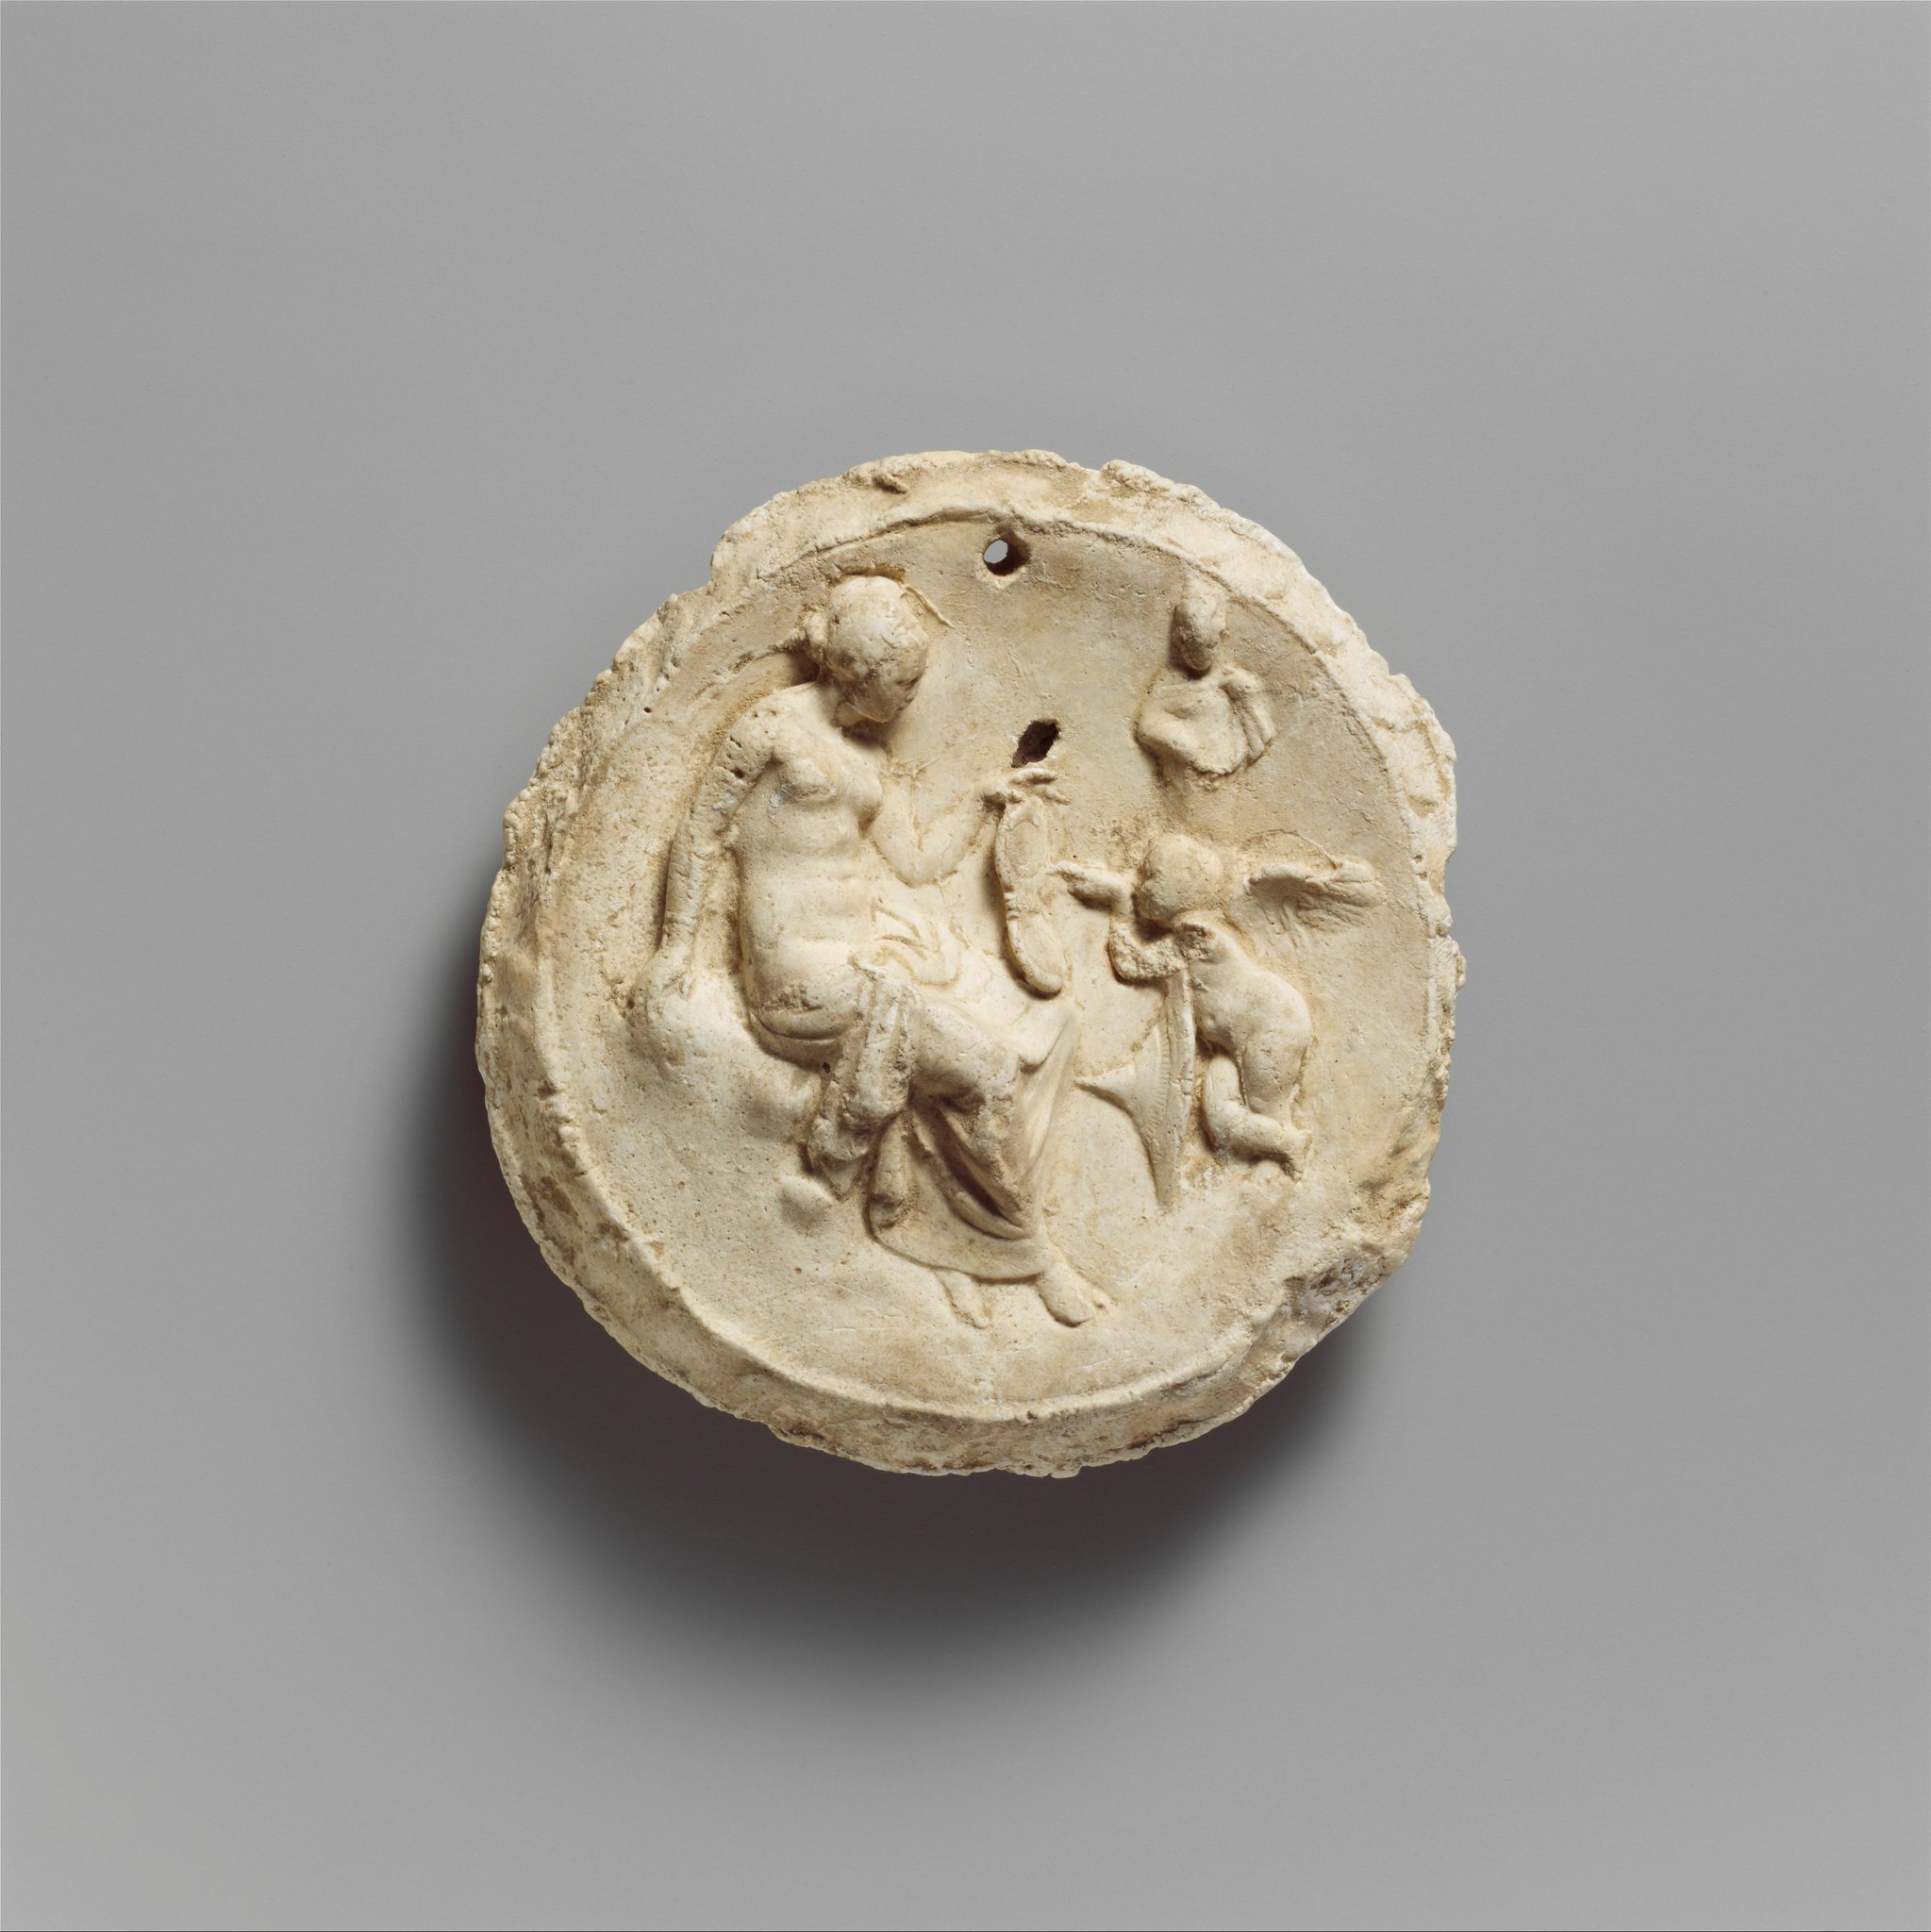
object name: emblema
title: Emblema with Aphrodite and Eros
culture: mediterranean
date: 1-200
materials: plaster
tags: gandhara,aphrodite,eros